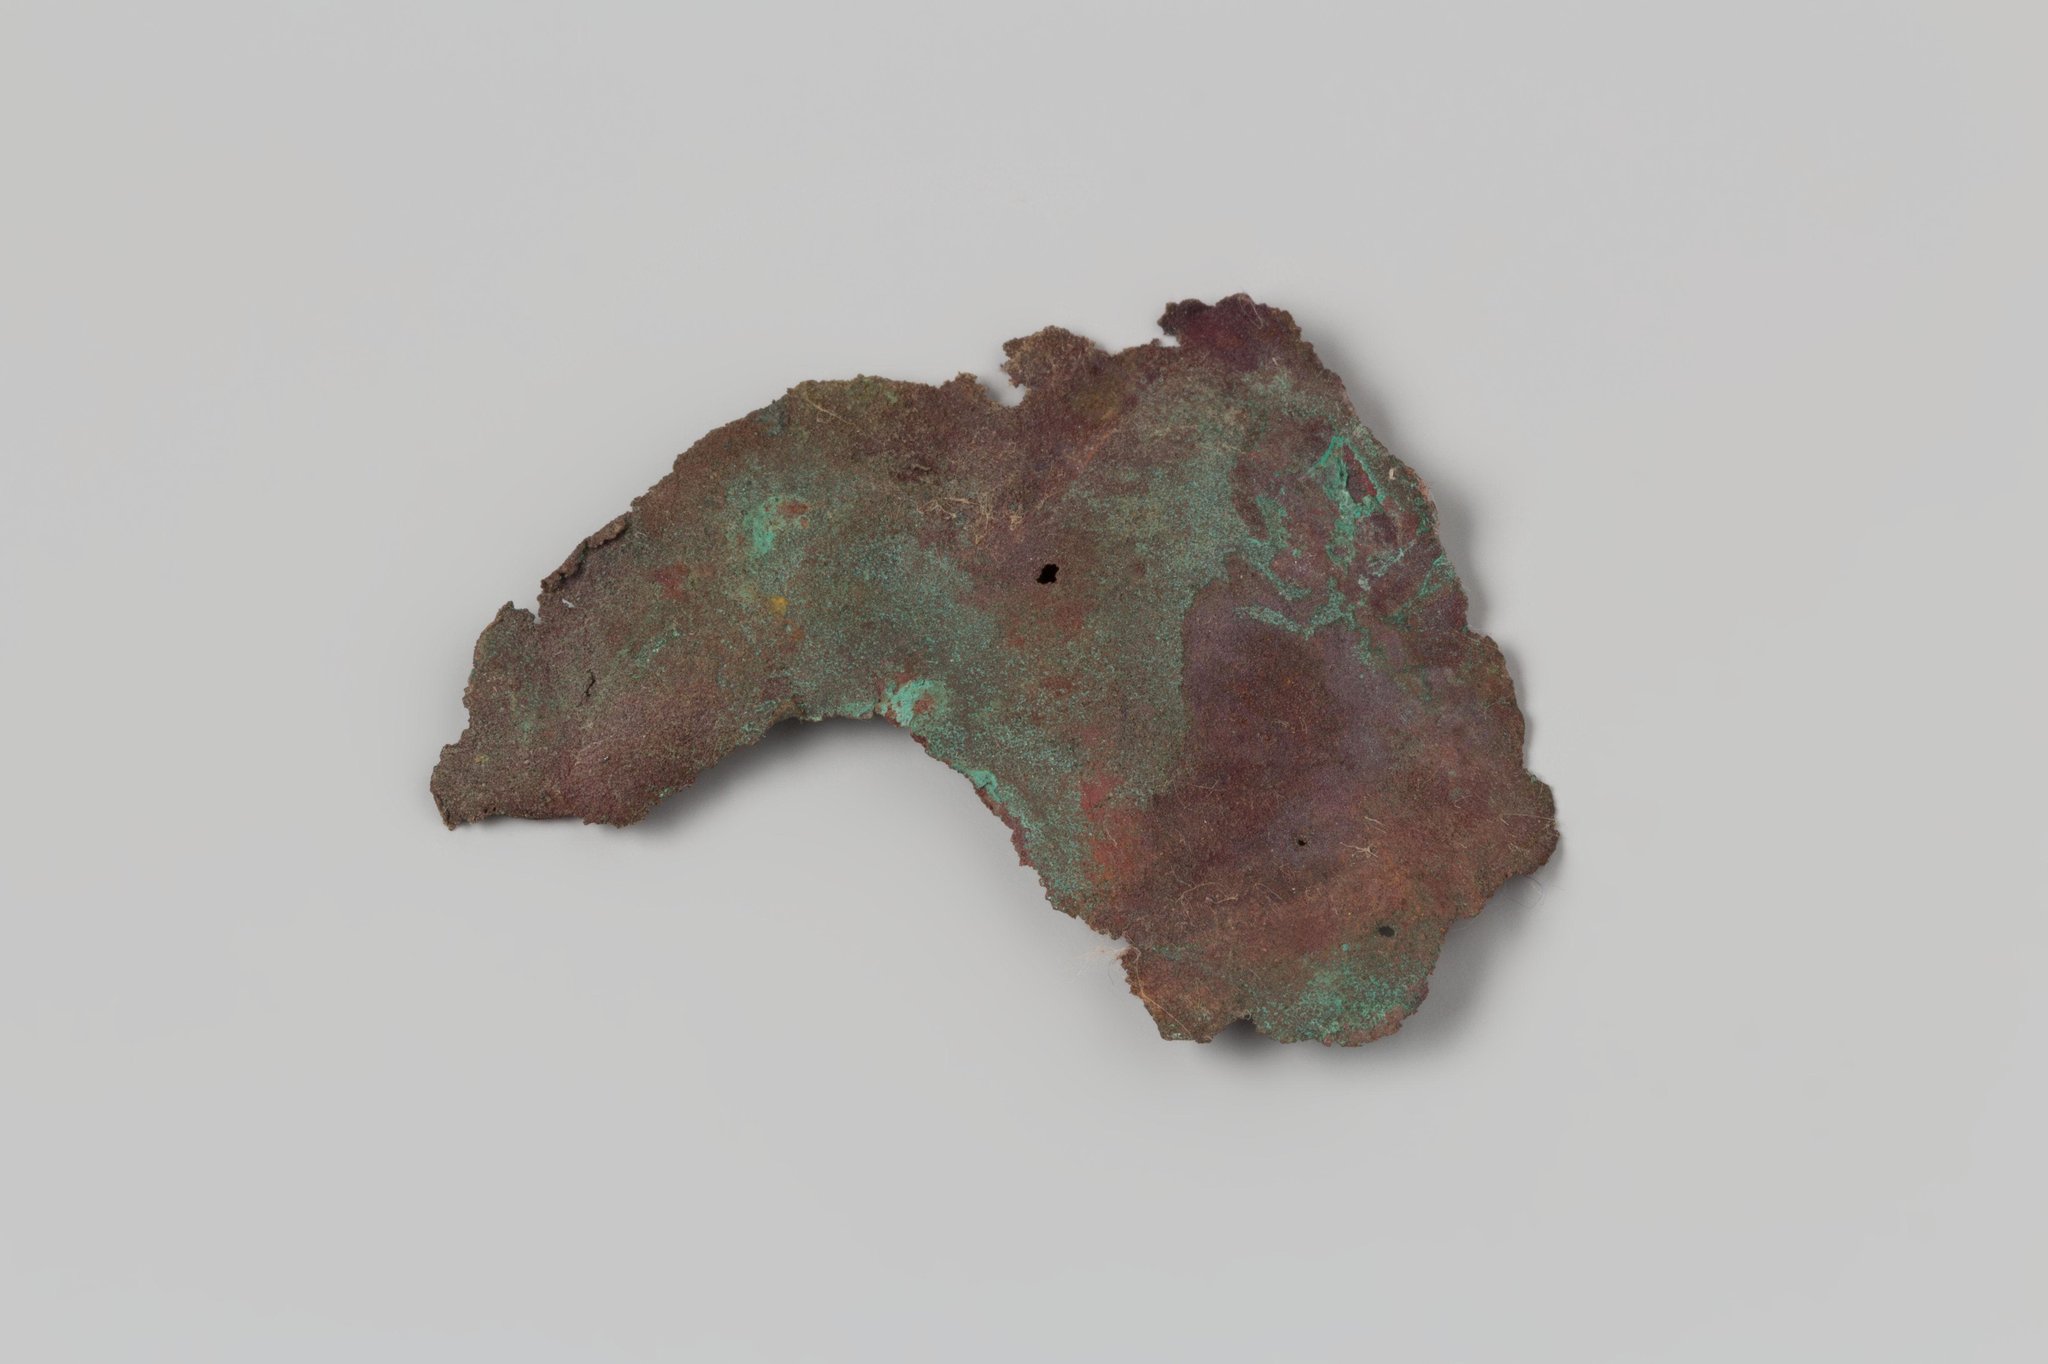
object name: scheepswrakvondst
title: Fragment van koper uit het wrak van de Oost-Indiëvaarder Hollandia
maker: Anonymous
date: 1700-1743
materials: copper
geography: netherlands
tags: verenigde oostindische compagnie, hollandia (schip), annet